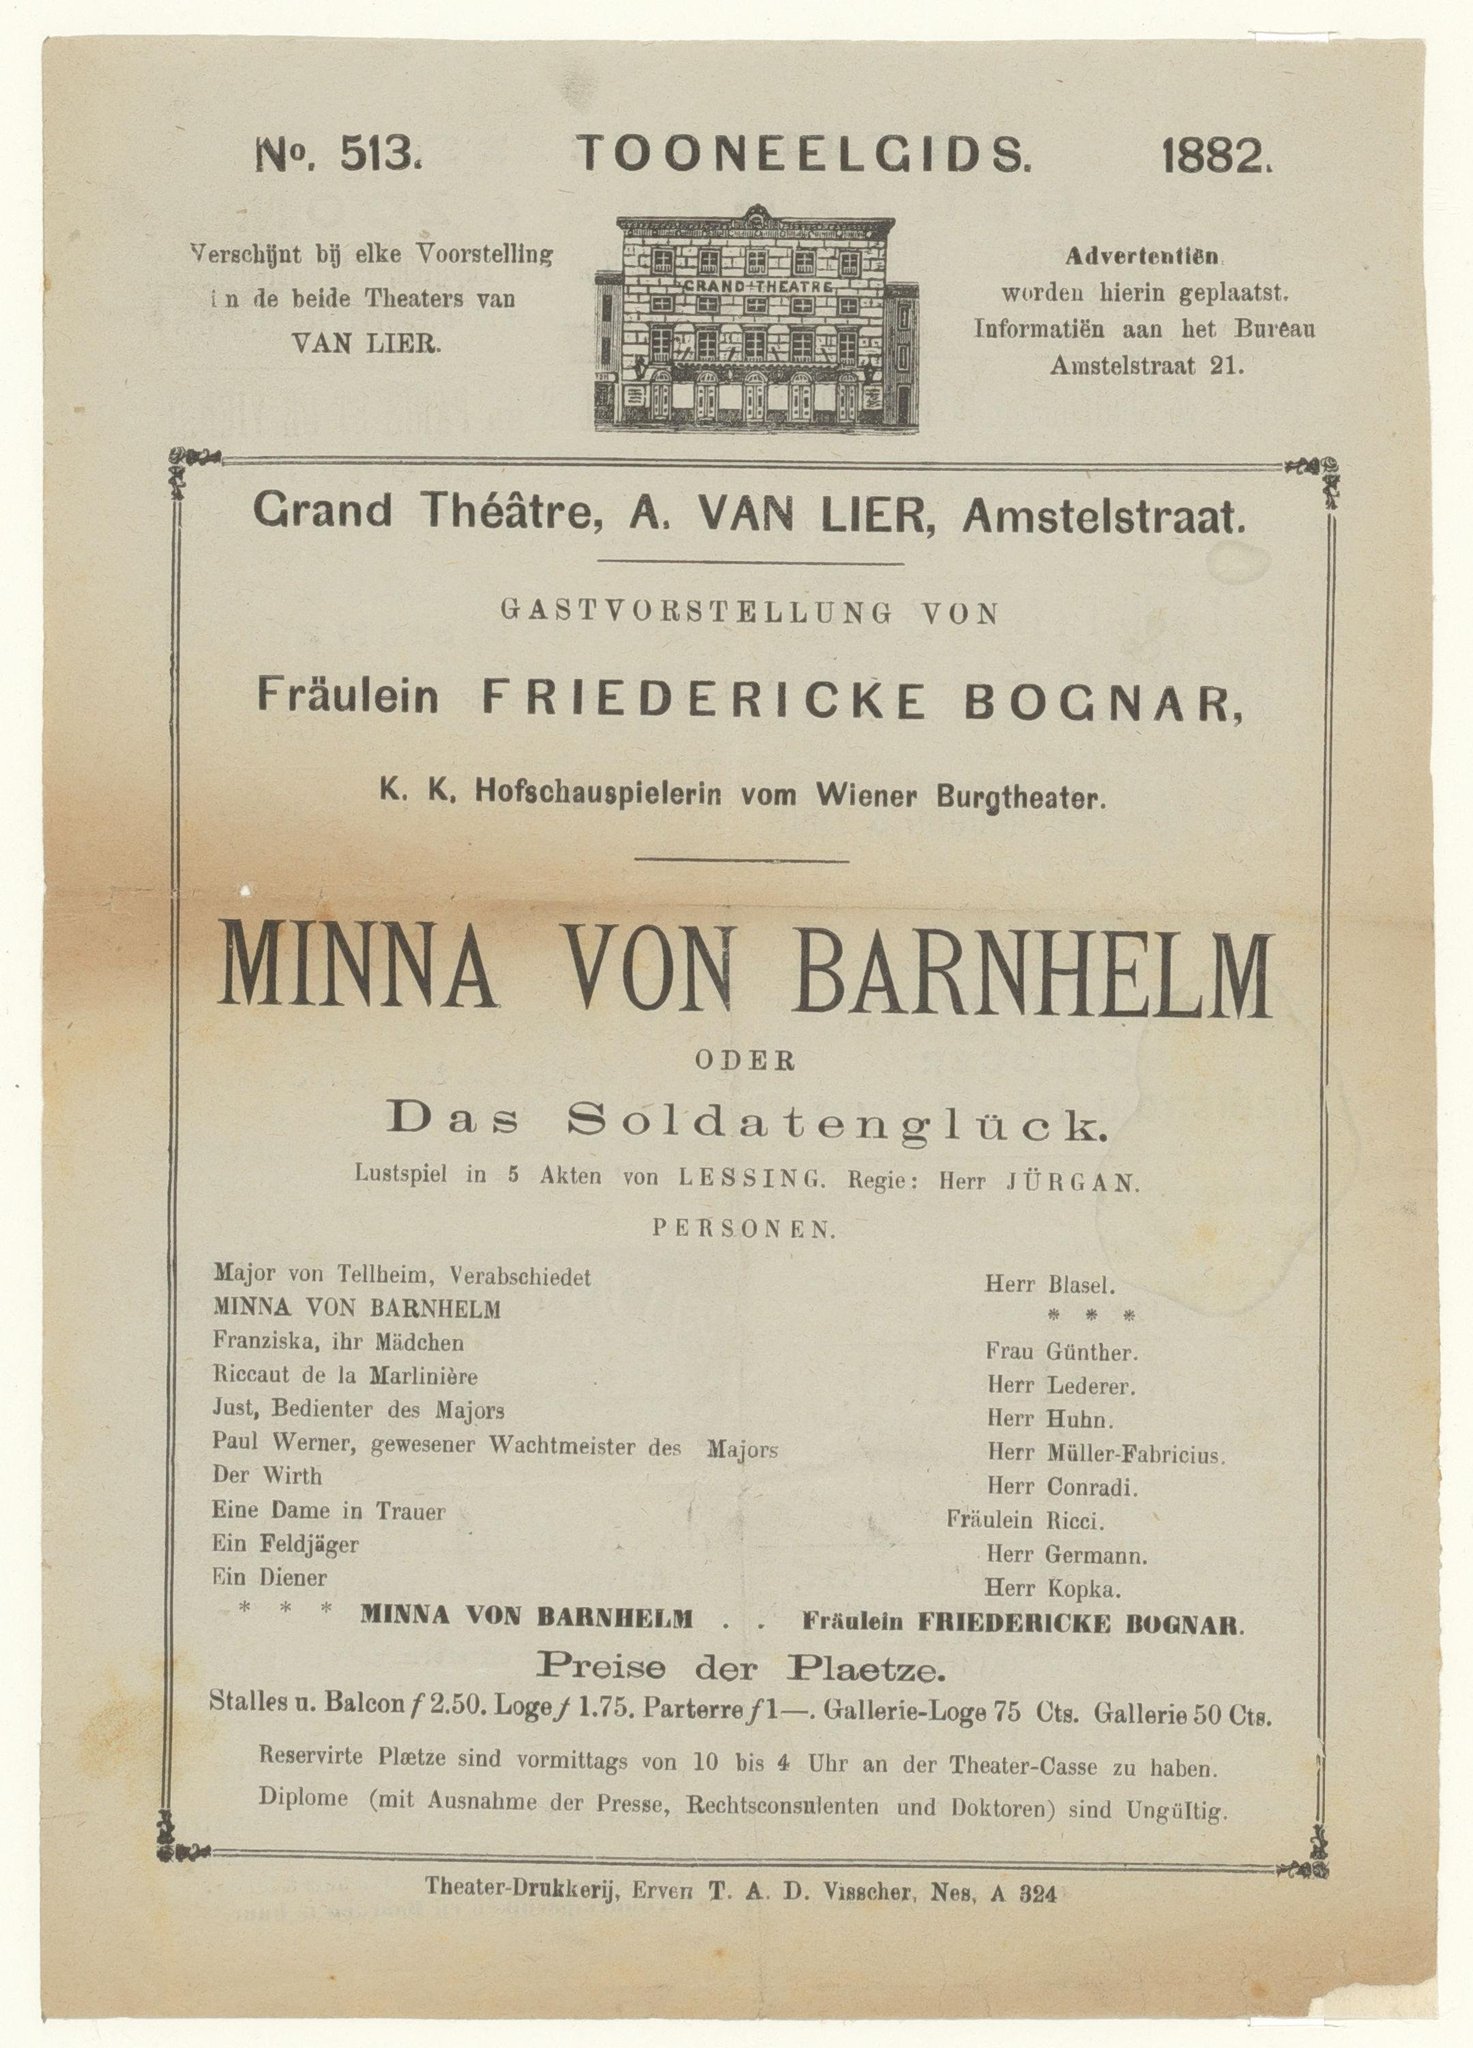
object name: text sheet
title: Tooneelgids, no. 513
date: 1882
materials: paper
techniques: letterpress printing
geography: amsterdam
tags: theatre, theatrical performance, art, amsterdam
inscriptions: stamp, collector's mark: Lugt 1641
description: Tooneelgids, verschijnt bij iedere voorstelling in de theaters van Van Lier. Dit is nummer No. 513, met de aankondiging van de voorstelling Minna von Barnhelm. Onderaan de rollen en namen van de acteurs en de prijzen van de tickets. Op het verso twee kolommen met advertenties. Onderwerpsrubrieken binnen de Atlas Zeden en Gewoonten: Tooneel, Toneelprogramma’s.